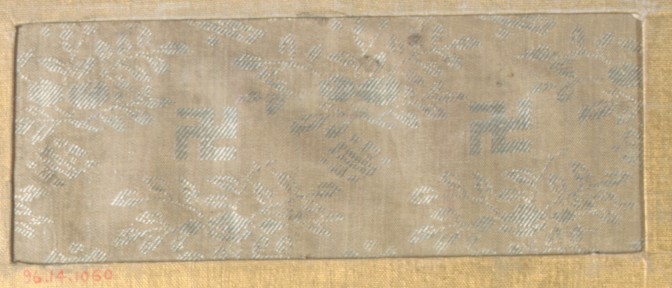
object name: piece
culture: japanese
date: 1701-1900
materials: silk